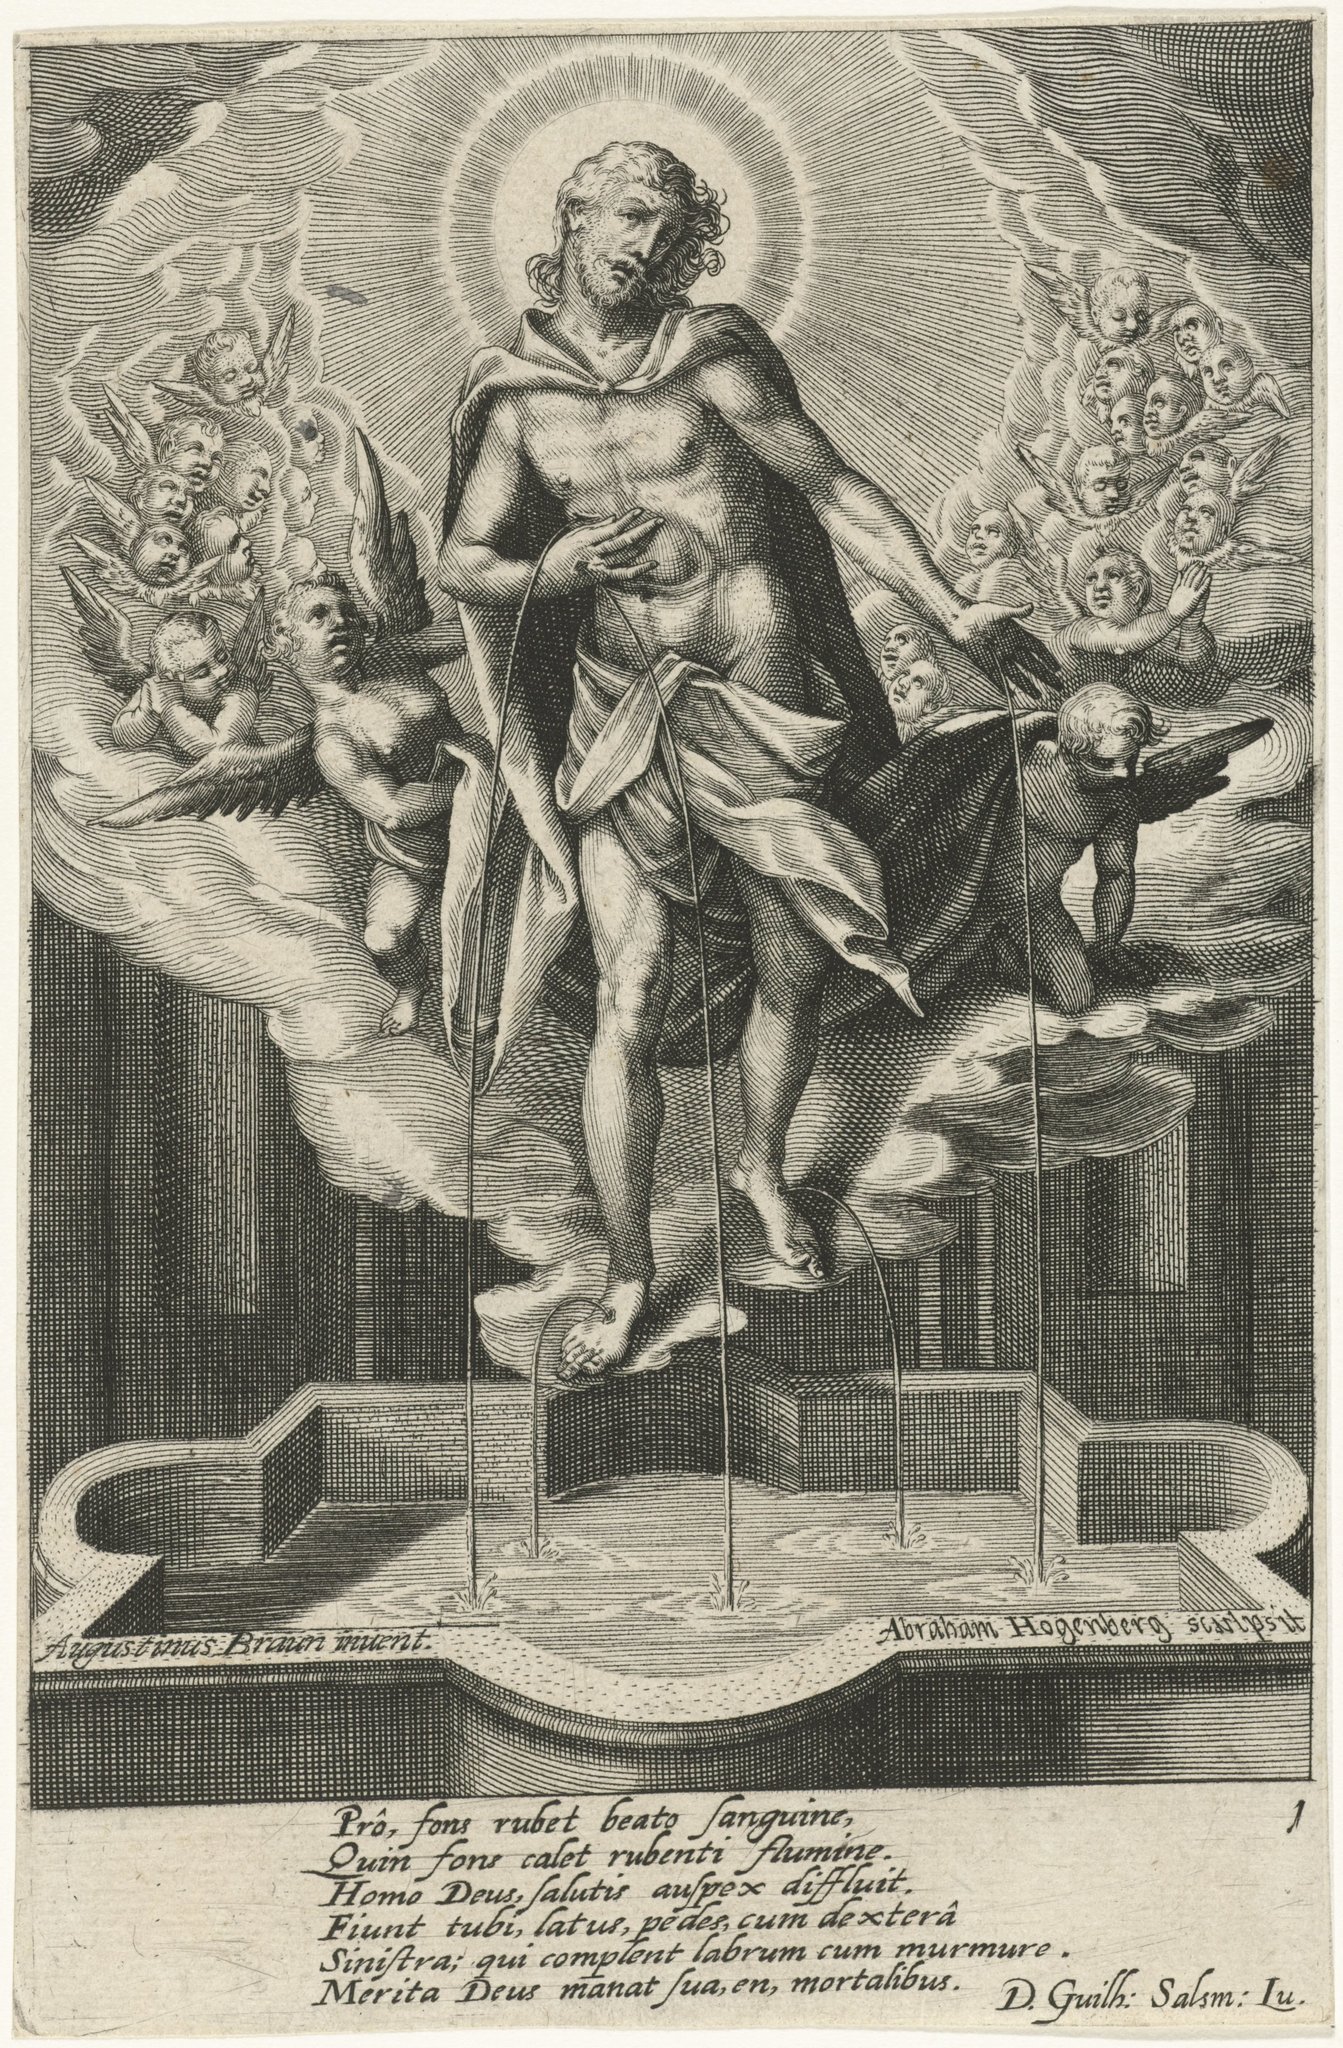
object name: print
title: Fons Vitae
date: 1608-1658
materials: paper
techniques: engraving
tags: christ standing on or near a fountain, shedding his blood (+ angel(s)), the instruments of the passion and the five wounded limbs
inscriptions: collector's mark: Lugt 2760, collector's mark: Lugt 1041c, collector's mark: Lugt 3791, collector's mark: Lugt 2228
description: Christus staand in fontein, zijn bloed vergietend uit zijn vijf wonden. Achter hem in de wolken twee rijen engelen en cherubijnen.